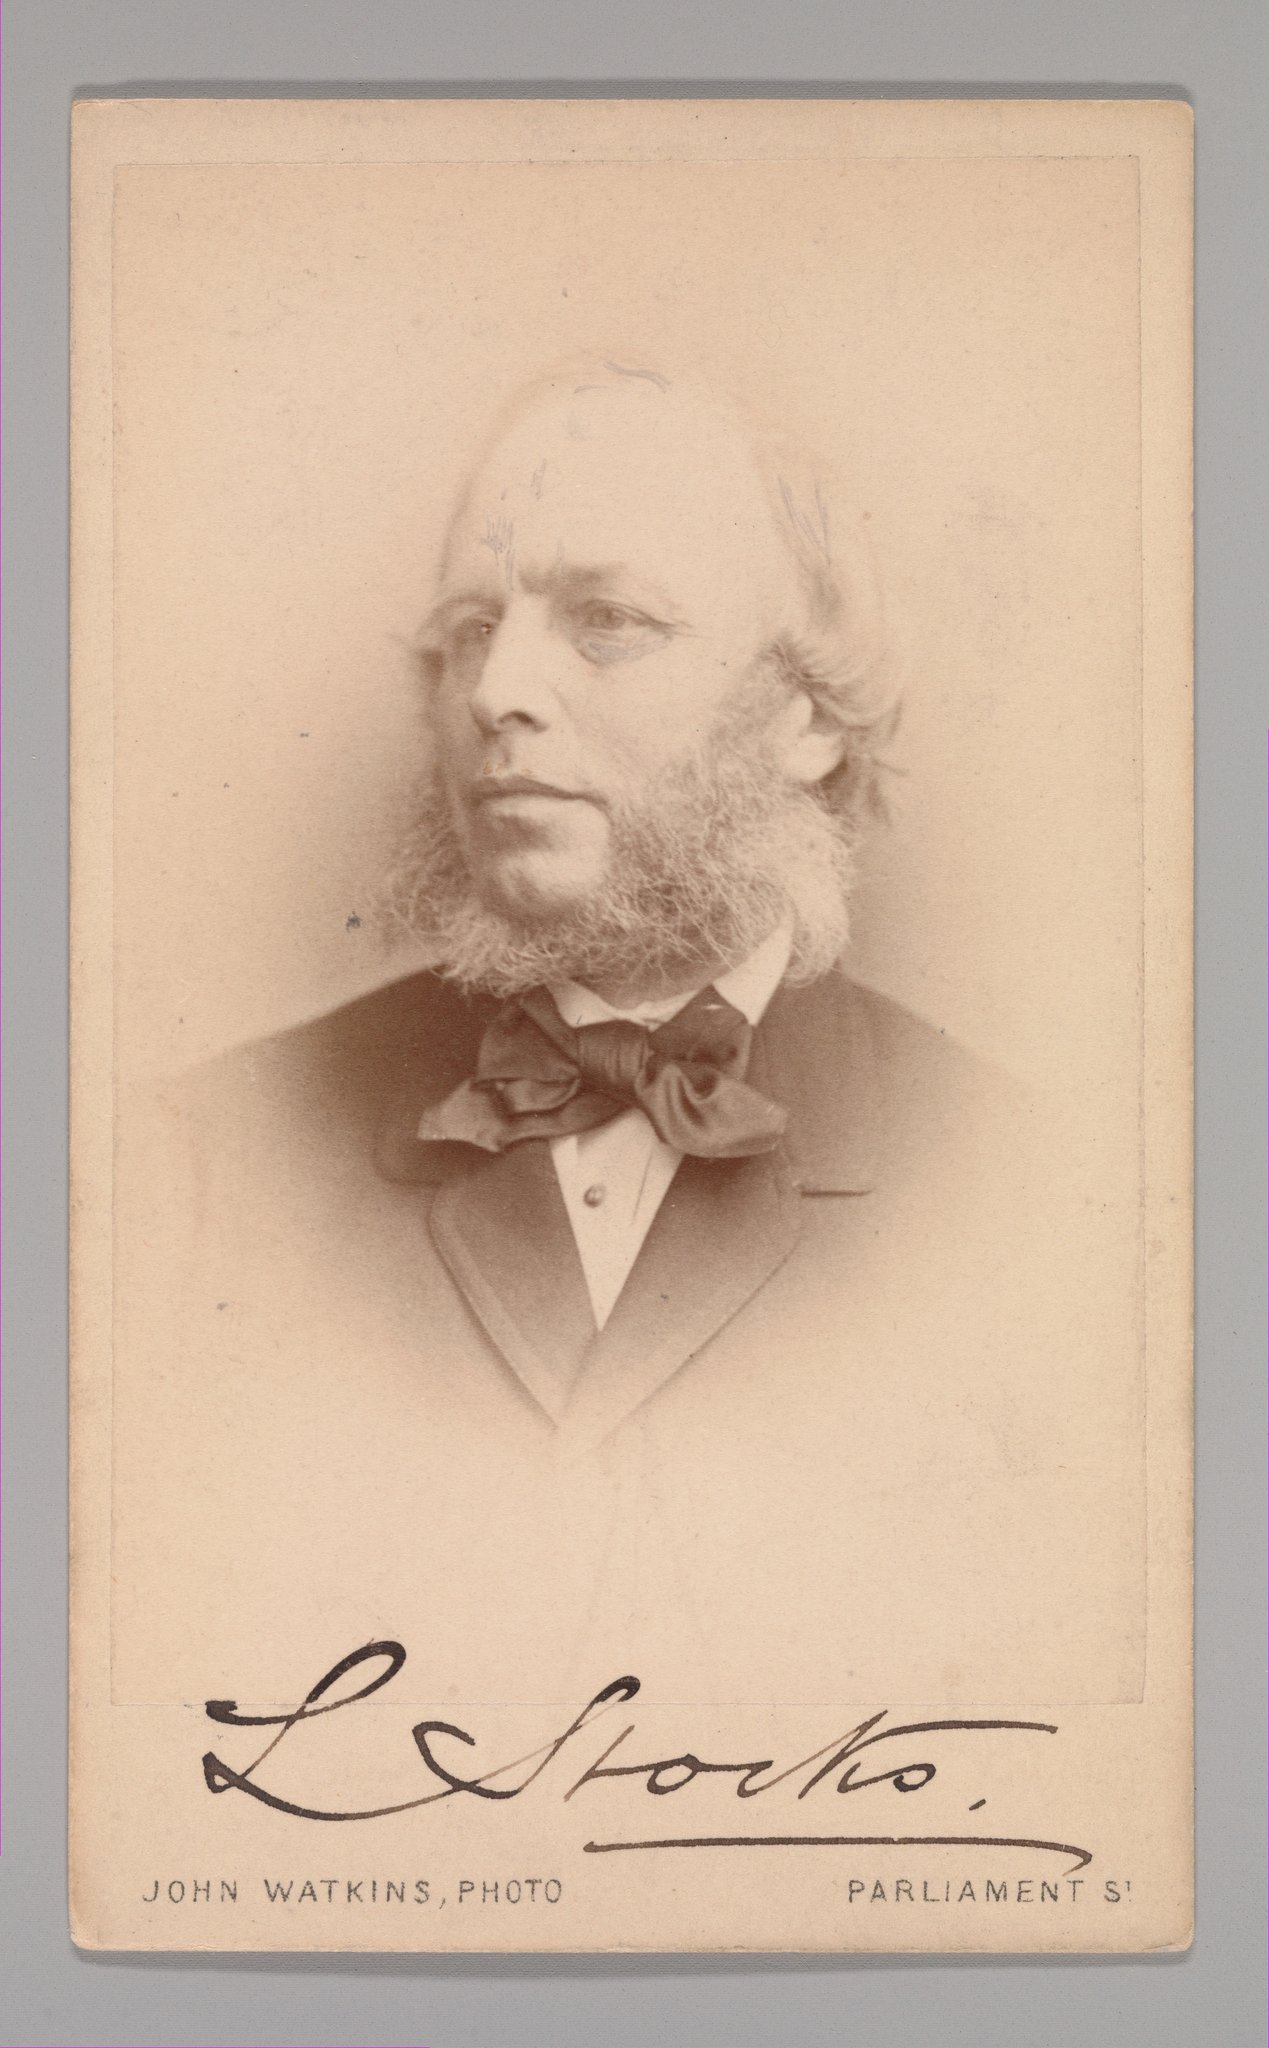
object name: carte de visite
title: [Lumb Stocks]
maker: john and charles watkins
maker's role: photography studio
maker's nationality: british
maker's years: 1840-1875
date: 1860-1869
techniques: albumen silver print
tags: men,portraits